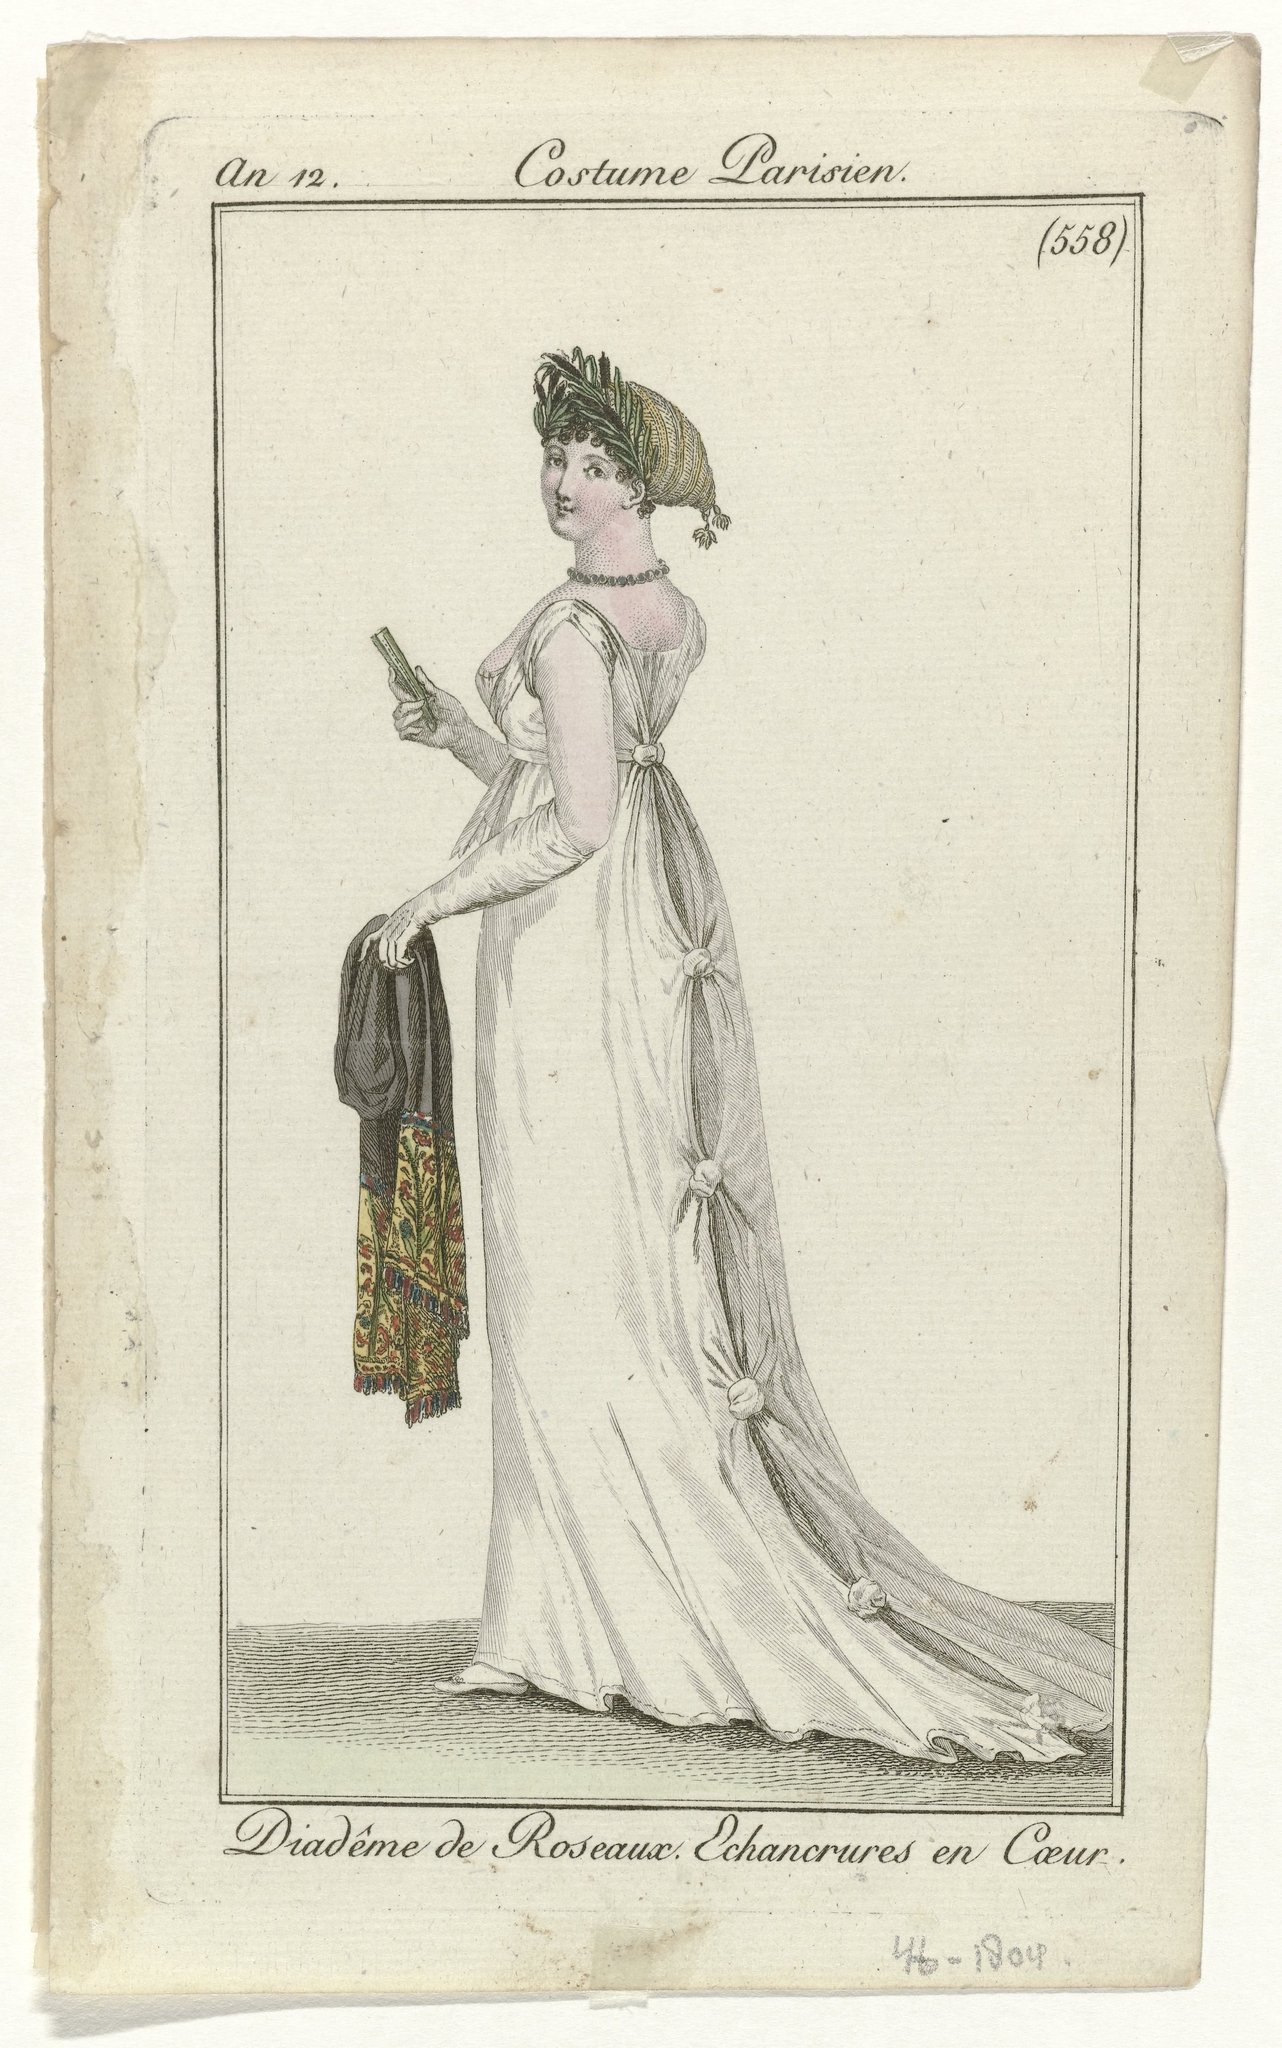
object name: fashion print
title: Journal des Dames et des Modes, Costume Parisien, 4 juin 1804, An 12, (558): Diadême de roseaux (...)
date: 1804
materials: paper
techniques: engraving, hand coloring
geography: paris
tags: clothing for the upper part of the body (+ women's clothes), diadem, tiara (+ women's clothes), gloves, mittens (long gloves) (+ women's clothes), clothing for the upper part of the body (shawl) (+ women's clothes), fashion plates, shoes, sandals (+ women's clothes), dress, gown (+ women's clothes), fan (+ women's clothes), necklace (+ women's clothes)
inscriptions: title: ‘Costume Parisien.’, caption: ‘Diadême de Roseaux. Echancrures en Coeur.’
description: Vrouw, op de rug gezien, met in het haar een diadeem van riet. Zij draagt een japon met middenachter uitsnijdingen. Korte mouwen en sleep. Verdere accessoires: collier, waaier, lange handschoenen, sjaal met bloem- en bladmotief, platte schoen. De prent maakt deel uit van het modetijdschrift Journal des Dames et des Modes, uitgegeven door Pierre de la Mésangère, Parijs, 1797-1839.